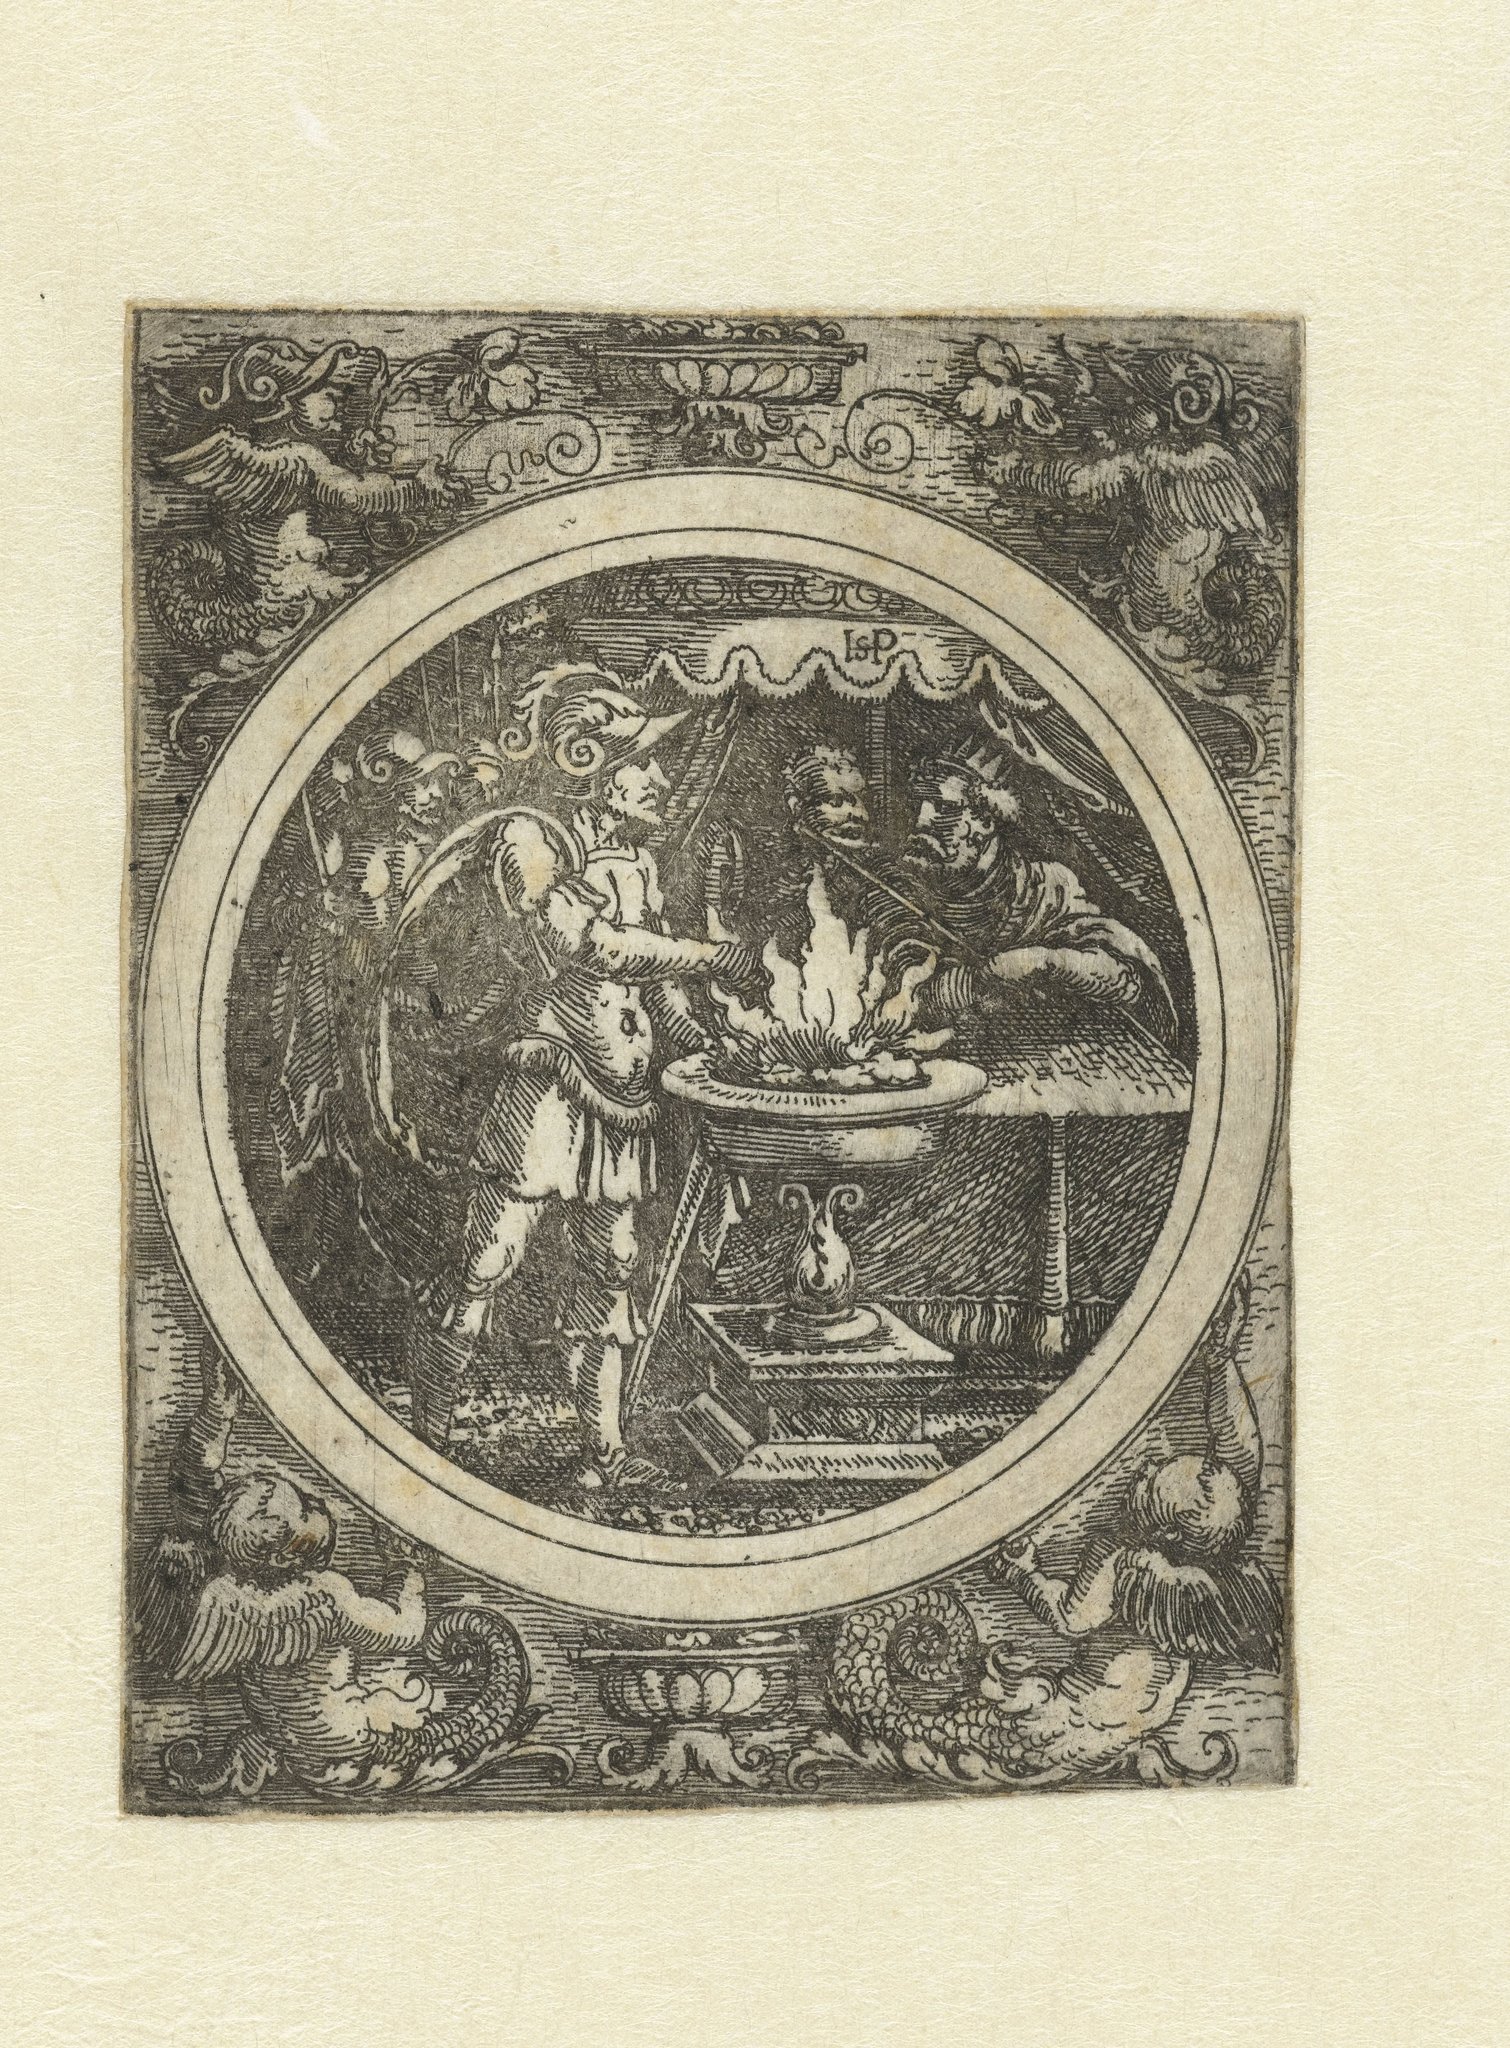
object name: print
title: Mucius Scaevola met zijn rechterhand in het vuur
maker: hans sebald beham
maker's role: designer, draughtsman, print maker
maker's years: 1500-1550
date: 1510-1550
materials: paper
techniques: engraving, etching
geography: germany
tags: gaius mucius scaevola before porsena: he thrusts his right hand into the flames (the body of the king's secretary who erroneously had been killed instead of porsena may be seen lying on the ground)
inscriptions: collector's mark: Lugt 2228a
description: Mucius Scaevola met zijn rechterhand in het vuur om zijn zelfbeheersing te tonen aan koning Lars Porsenna. Het medaillon met deze voorstelling is geplaatst op een rechthoekig formaat met in de hoeken vier putti met een slangenstaart.